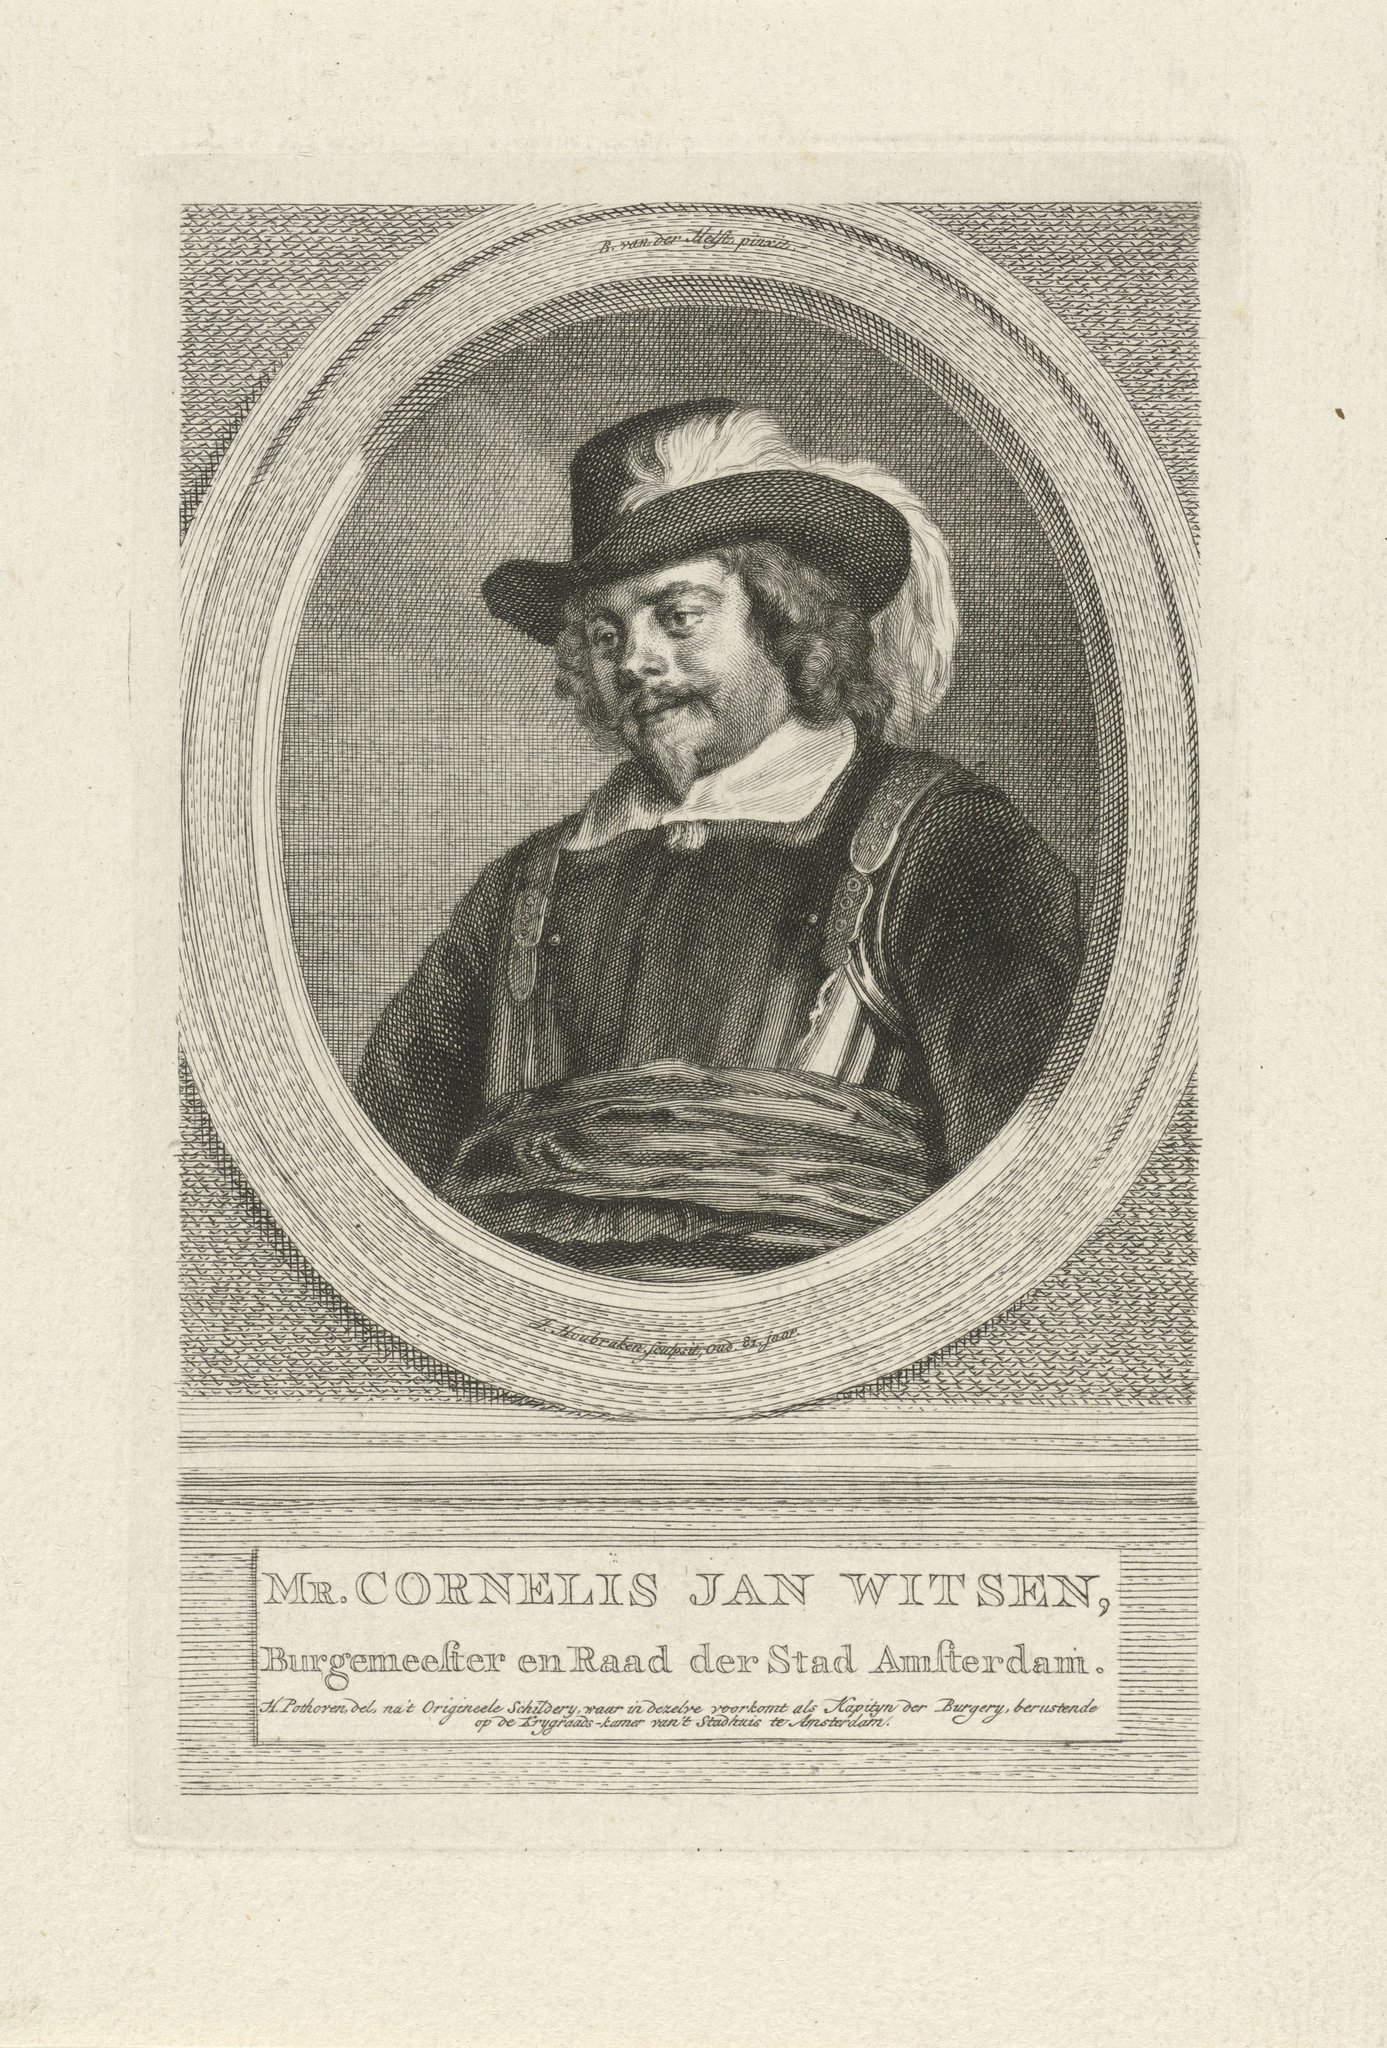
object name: print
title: Portret van Cornelis Witsen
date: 1779-1780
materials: paper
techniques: engraving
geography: amsterdam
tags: mayor, cornelis witsen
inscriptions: collector's mark: Lugt 2228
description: Latere staat prent waarschijnlijk uit: Wagenaar, Jan. Amsterdam in zyne opkomst, aanwas, geschiedenissen, (...). Amsterdam: Isaak Tirion, 1765, vol. 7. De prenten zijn tussen 1765 en 1786 in dit boek gevoegd. Zie: Compleete lyst of register van alle de portraiten en plaaten, (...). Amsterdam: A. van der Kroe en A. Capel, 1786.